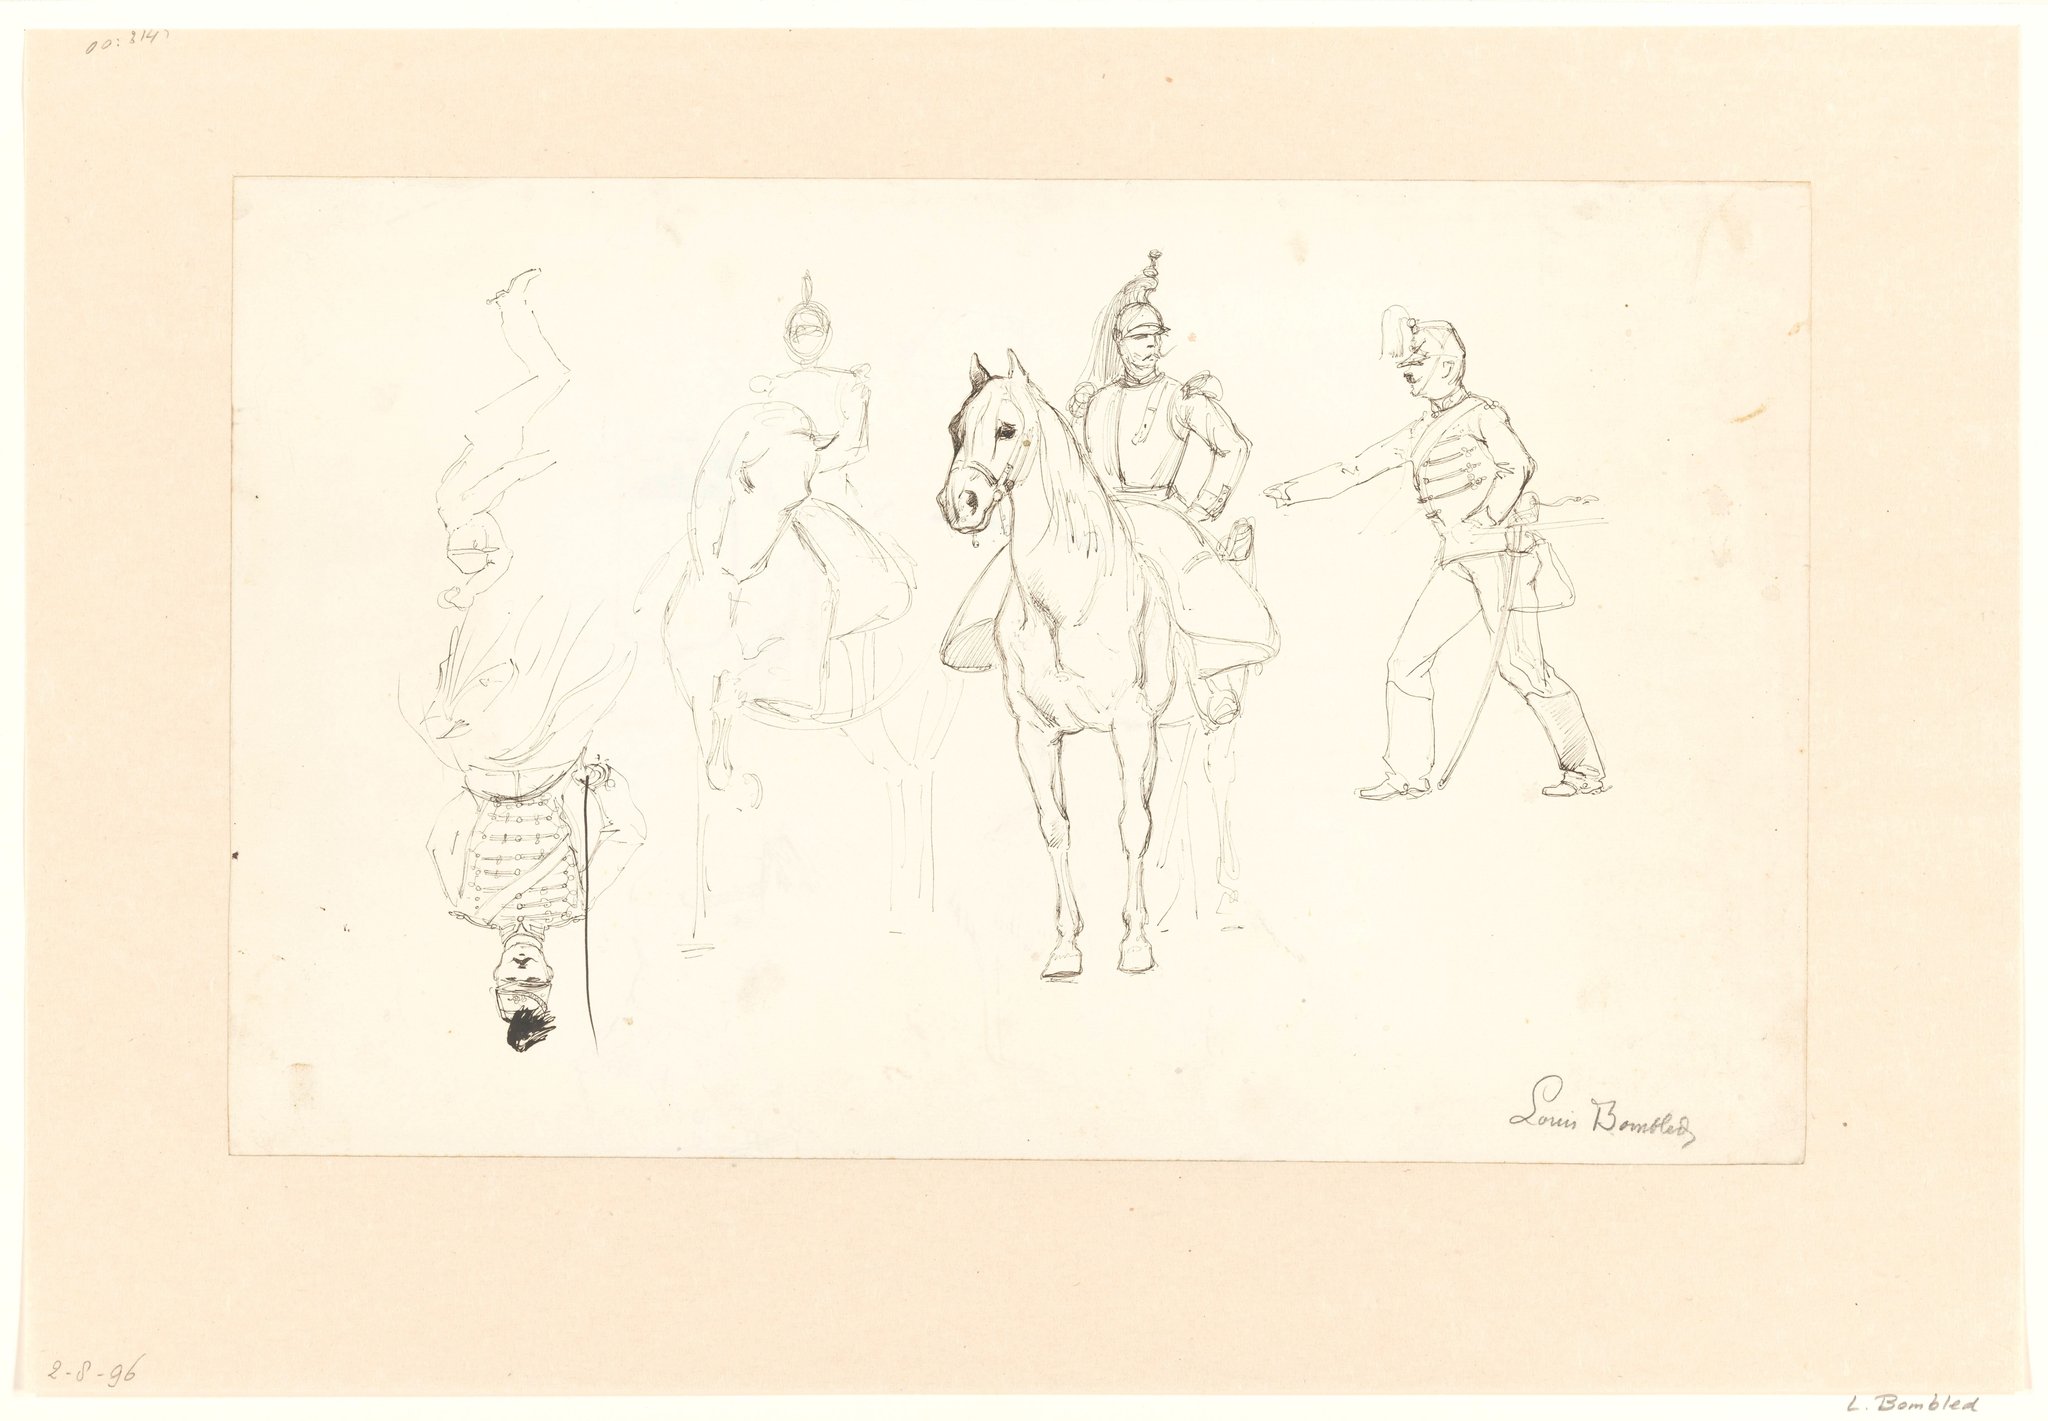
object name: drawing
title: Schetsblad met studies van militairen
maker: louis charles bombled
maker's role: draughtsman, print maker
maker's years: 1862-1927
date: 1872-1927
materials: ink, paper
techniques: pen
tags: land forces (+ cavalry, horsemen)